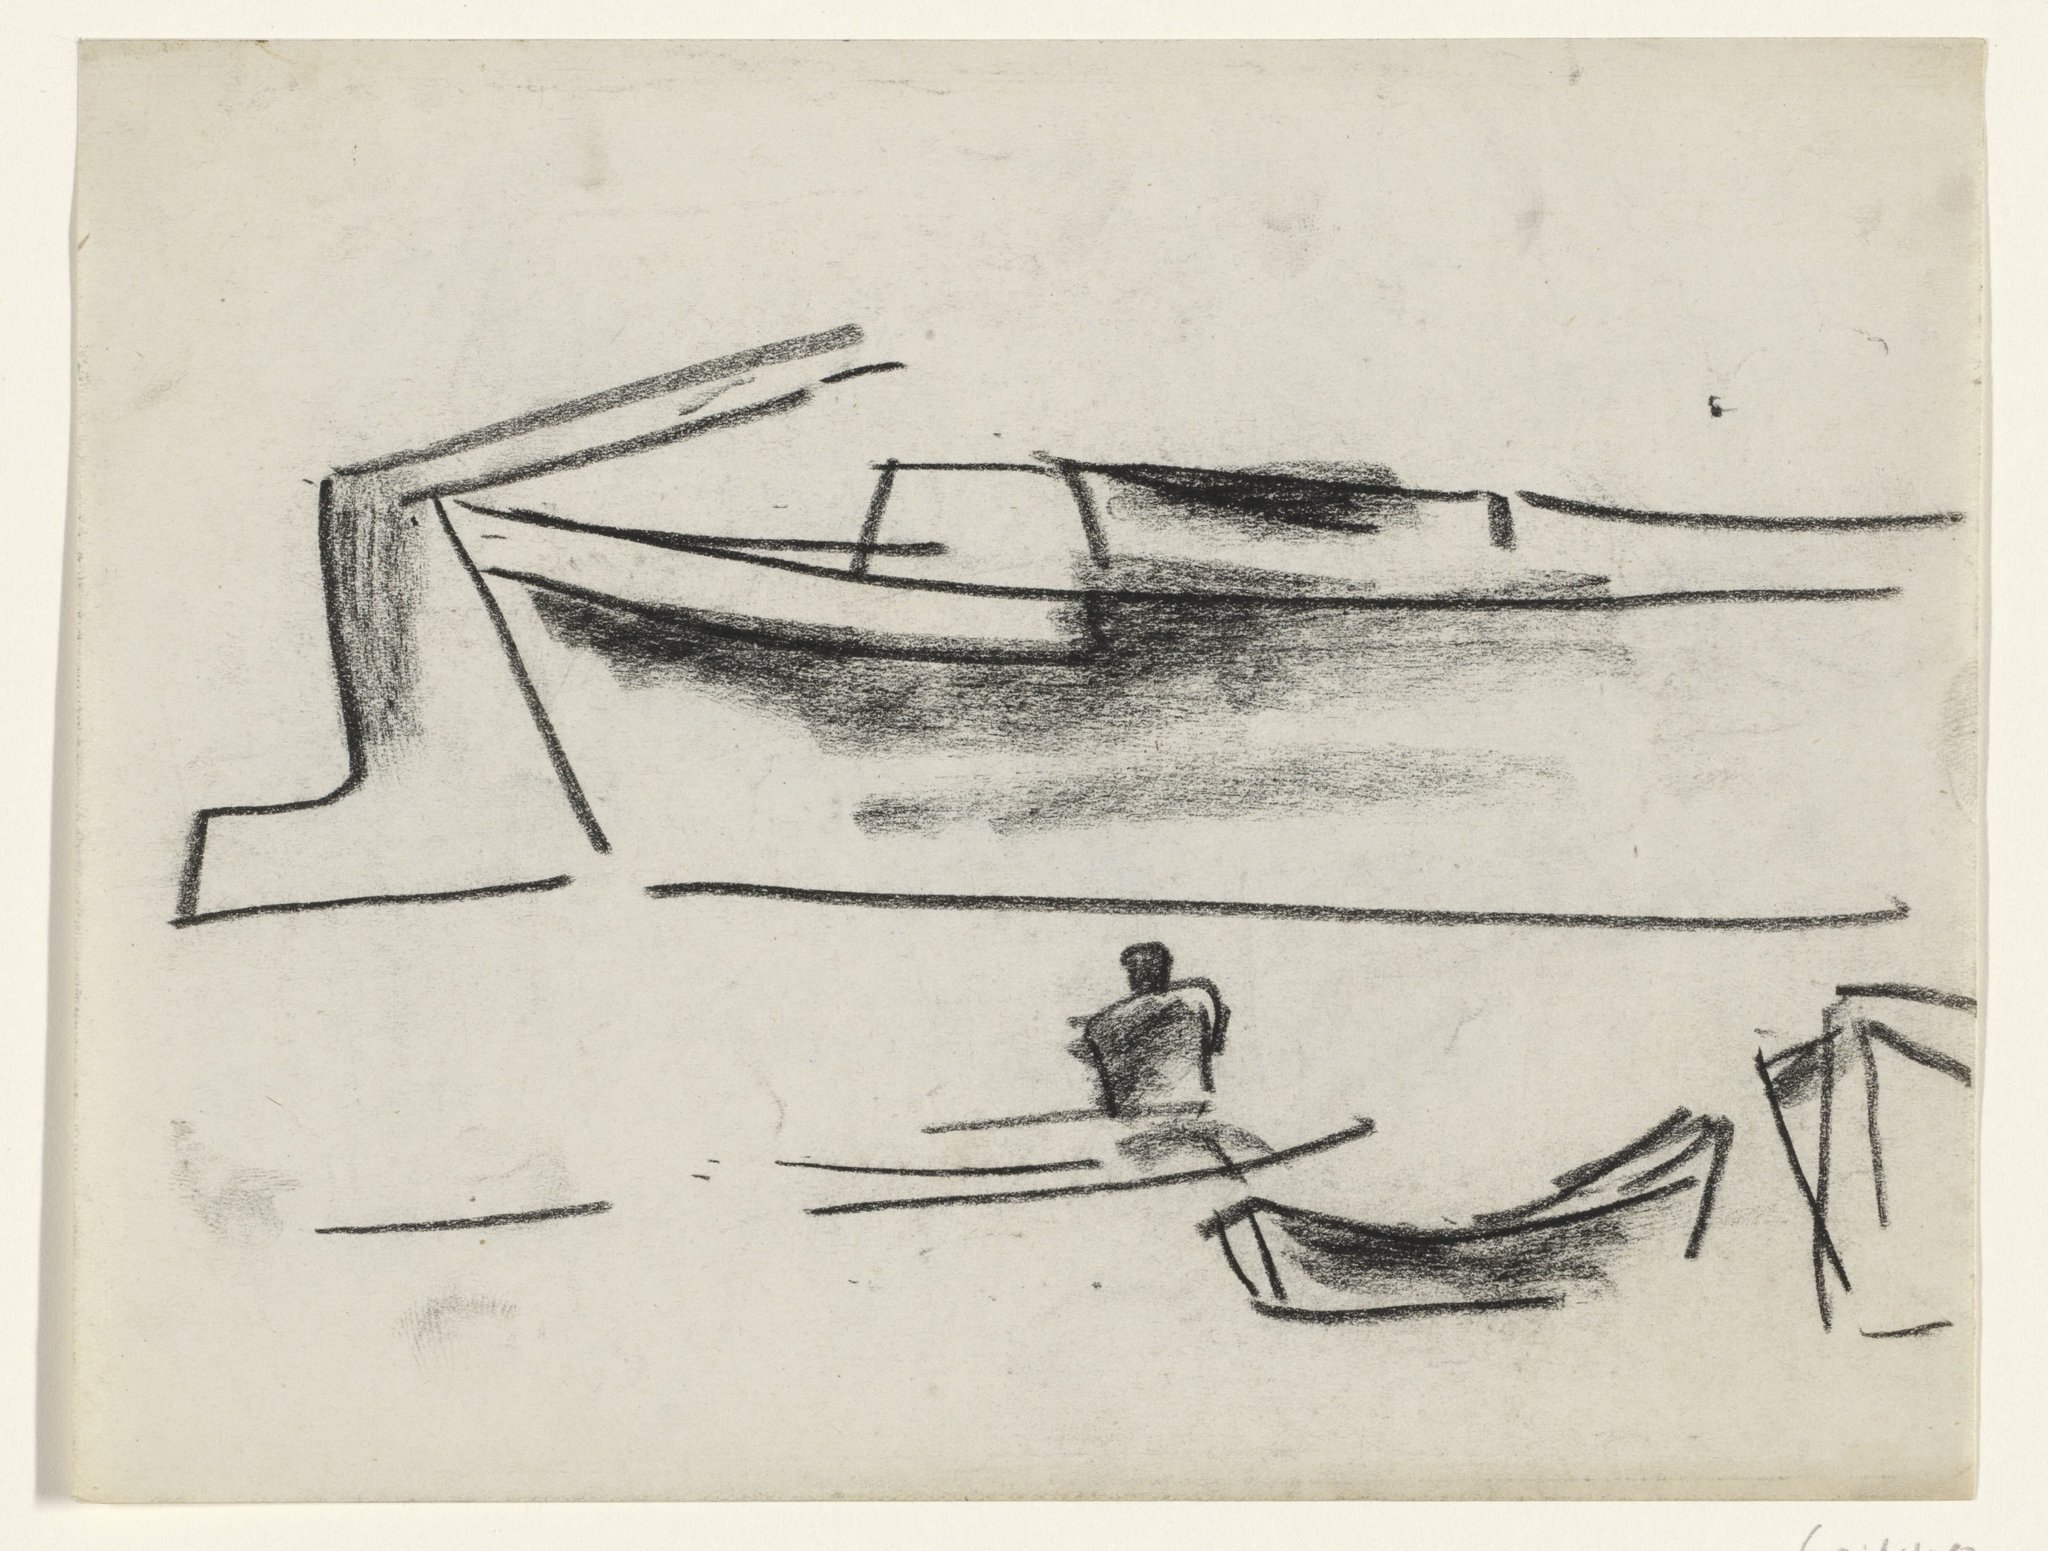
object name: drawing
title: Schip en een roeiboot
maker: leo gestel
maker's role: draughtsman, print maker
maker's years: 1881-1941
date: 1891-1941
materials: chalk, paper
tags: ships (in general), rowing-boat, canoe, etc.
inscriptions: collector's mark: Lugt 2228